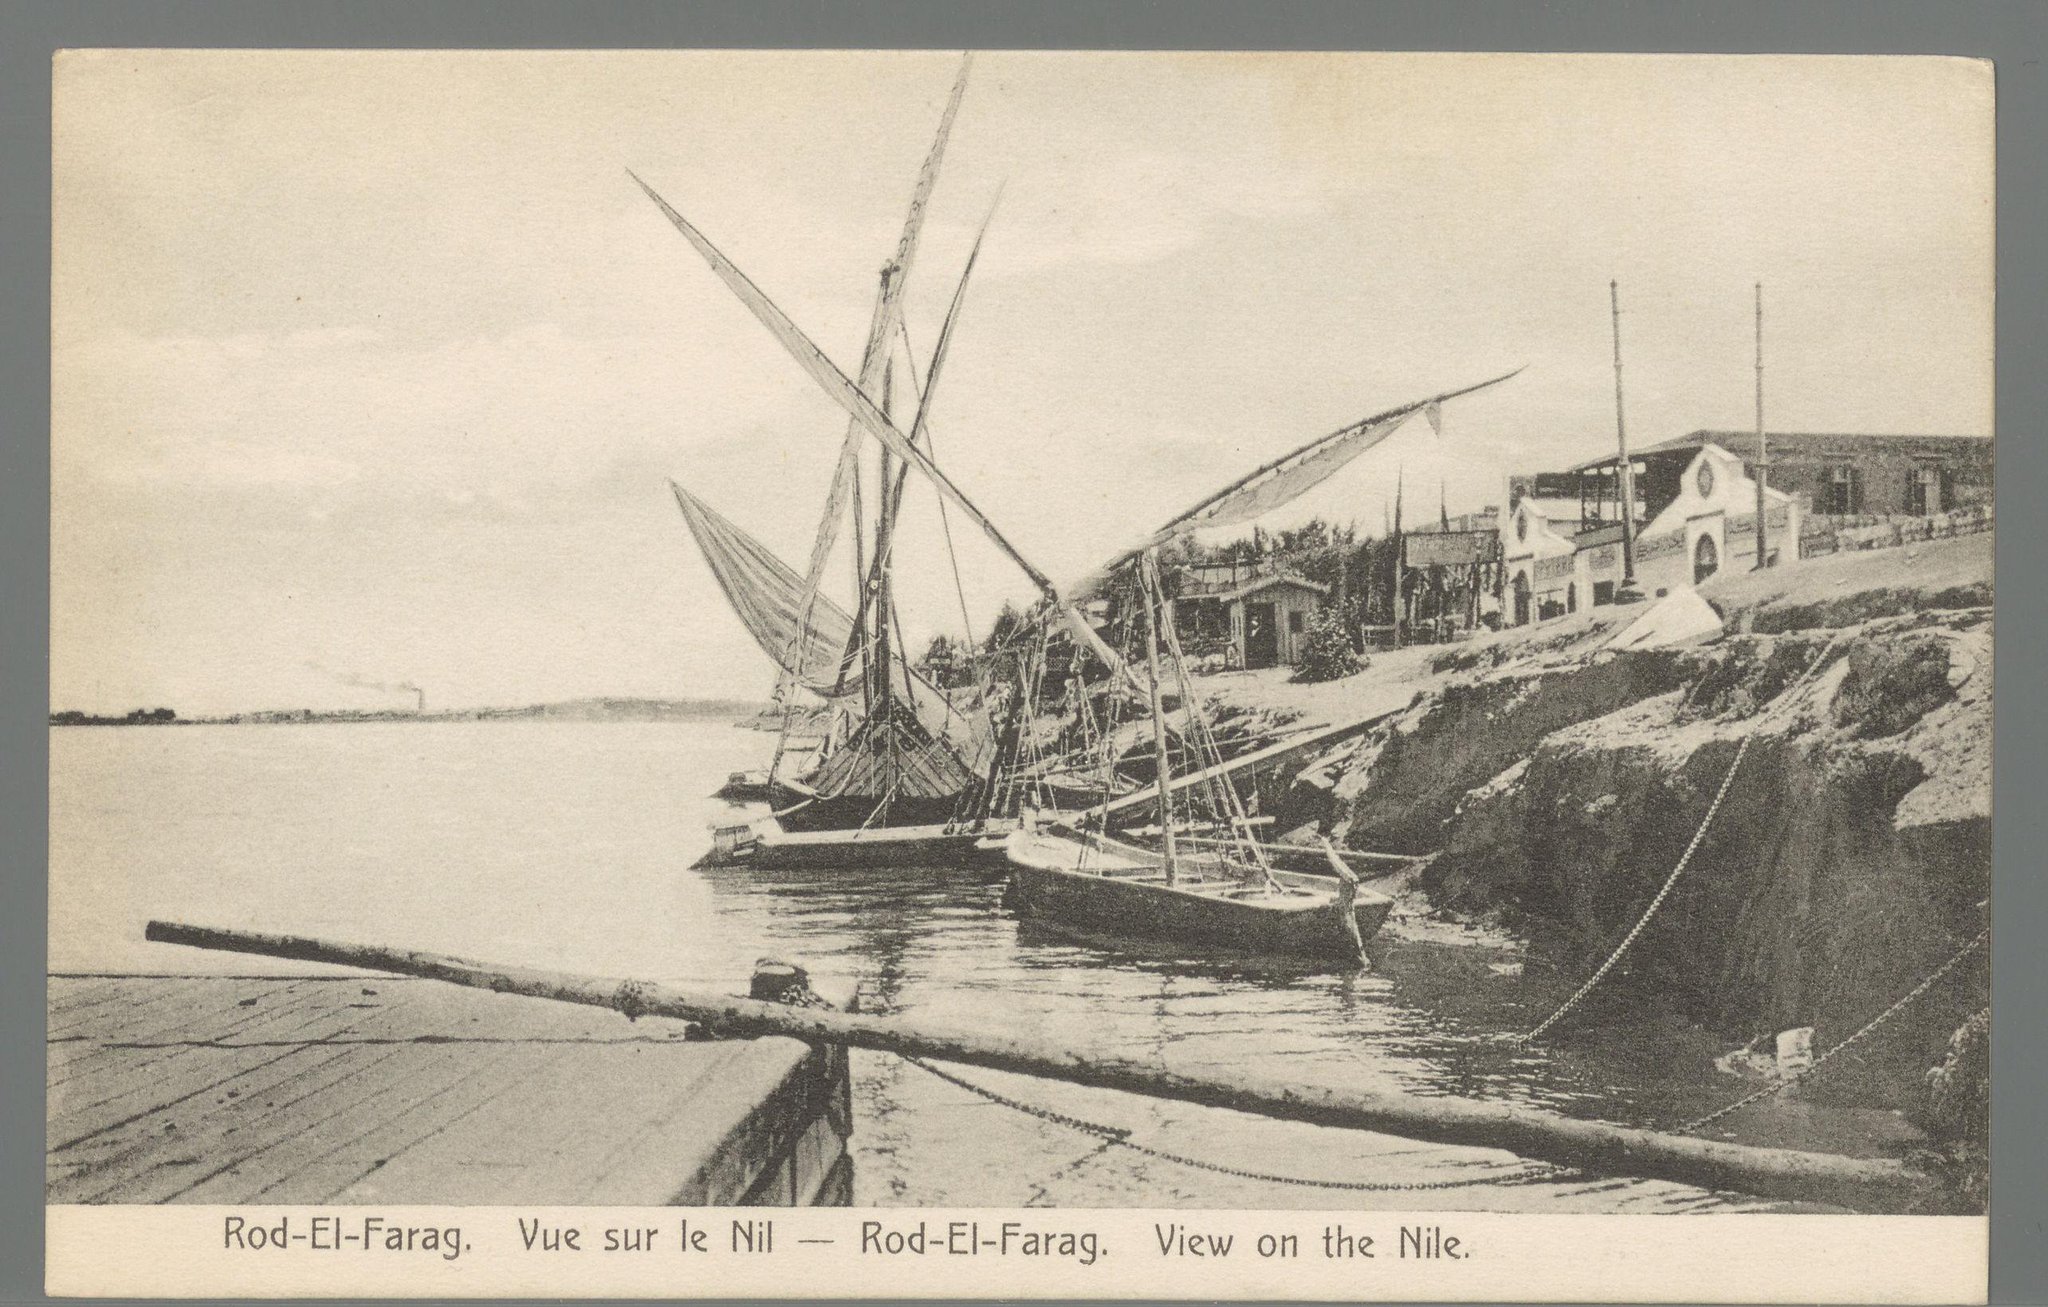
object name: photomechanical print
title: Rod-El-Farag. Vue sur le Nil / Rod-El-Farag. View on the Nile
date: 1907-1930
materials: cardboard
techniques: photograph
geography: cairo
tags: sailing-ship, sailing-boat, river